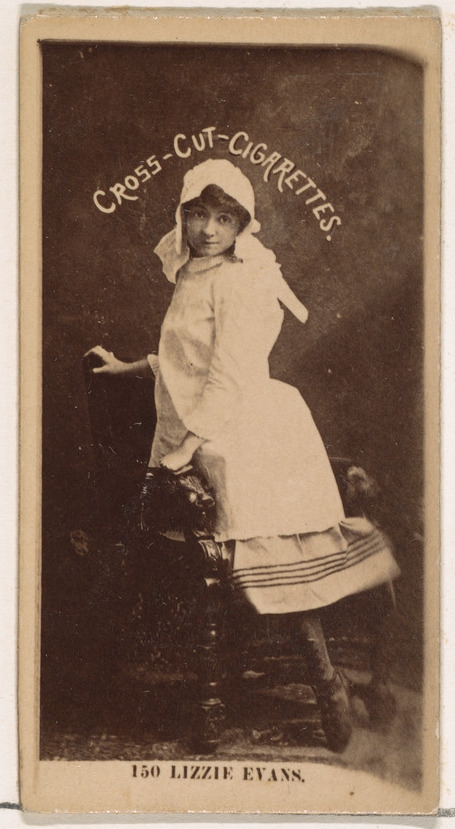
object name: print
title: Card Number 150, Lizzie Evans, from the Actors and Actresses series (N145-2) issued by Duke Sons & Co. to promote Cross Cut Cigarettes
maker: w. duke, sons & co.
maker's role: publisher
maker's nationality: american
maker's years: 1870-1920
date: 1880-1889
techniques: albumen silver print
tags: portraits,women,actresses